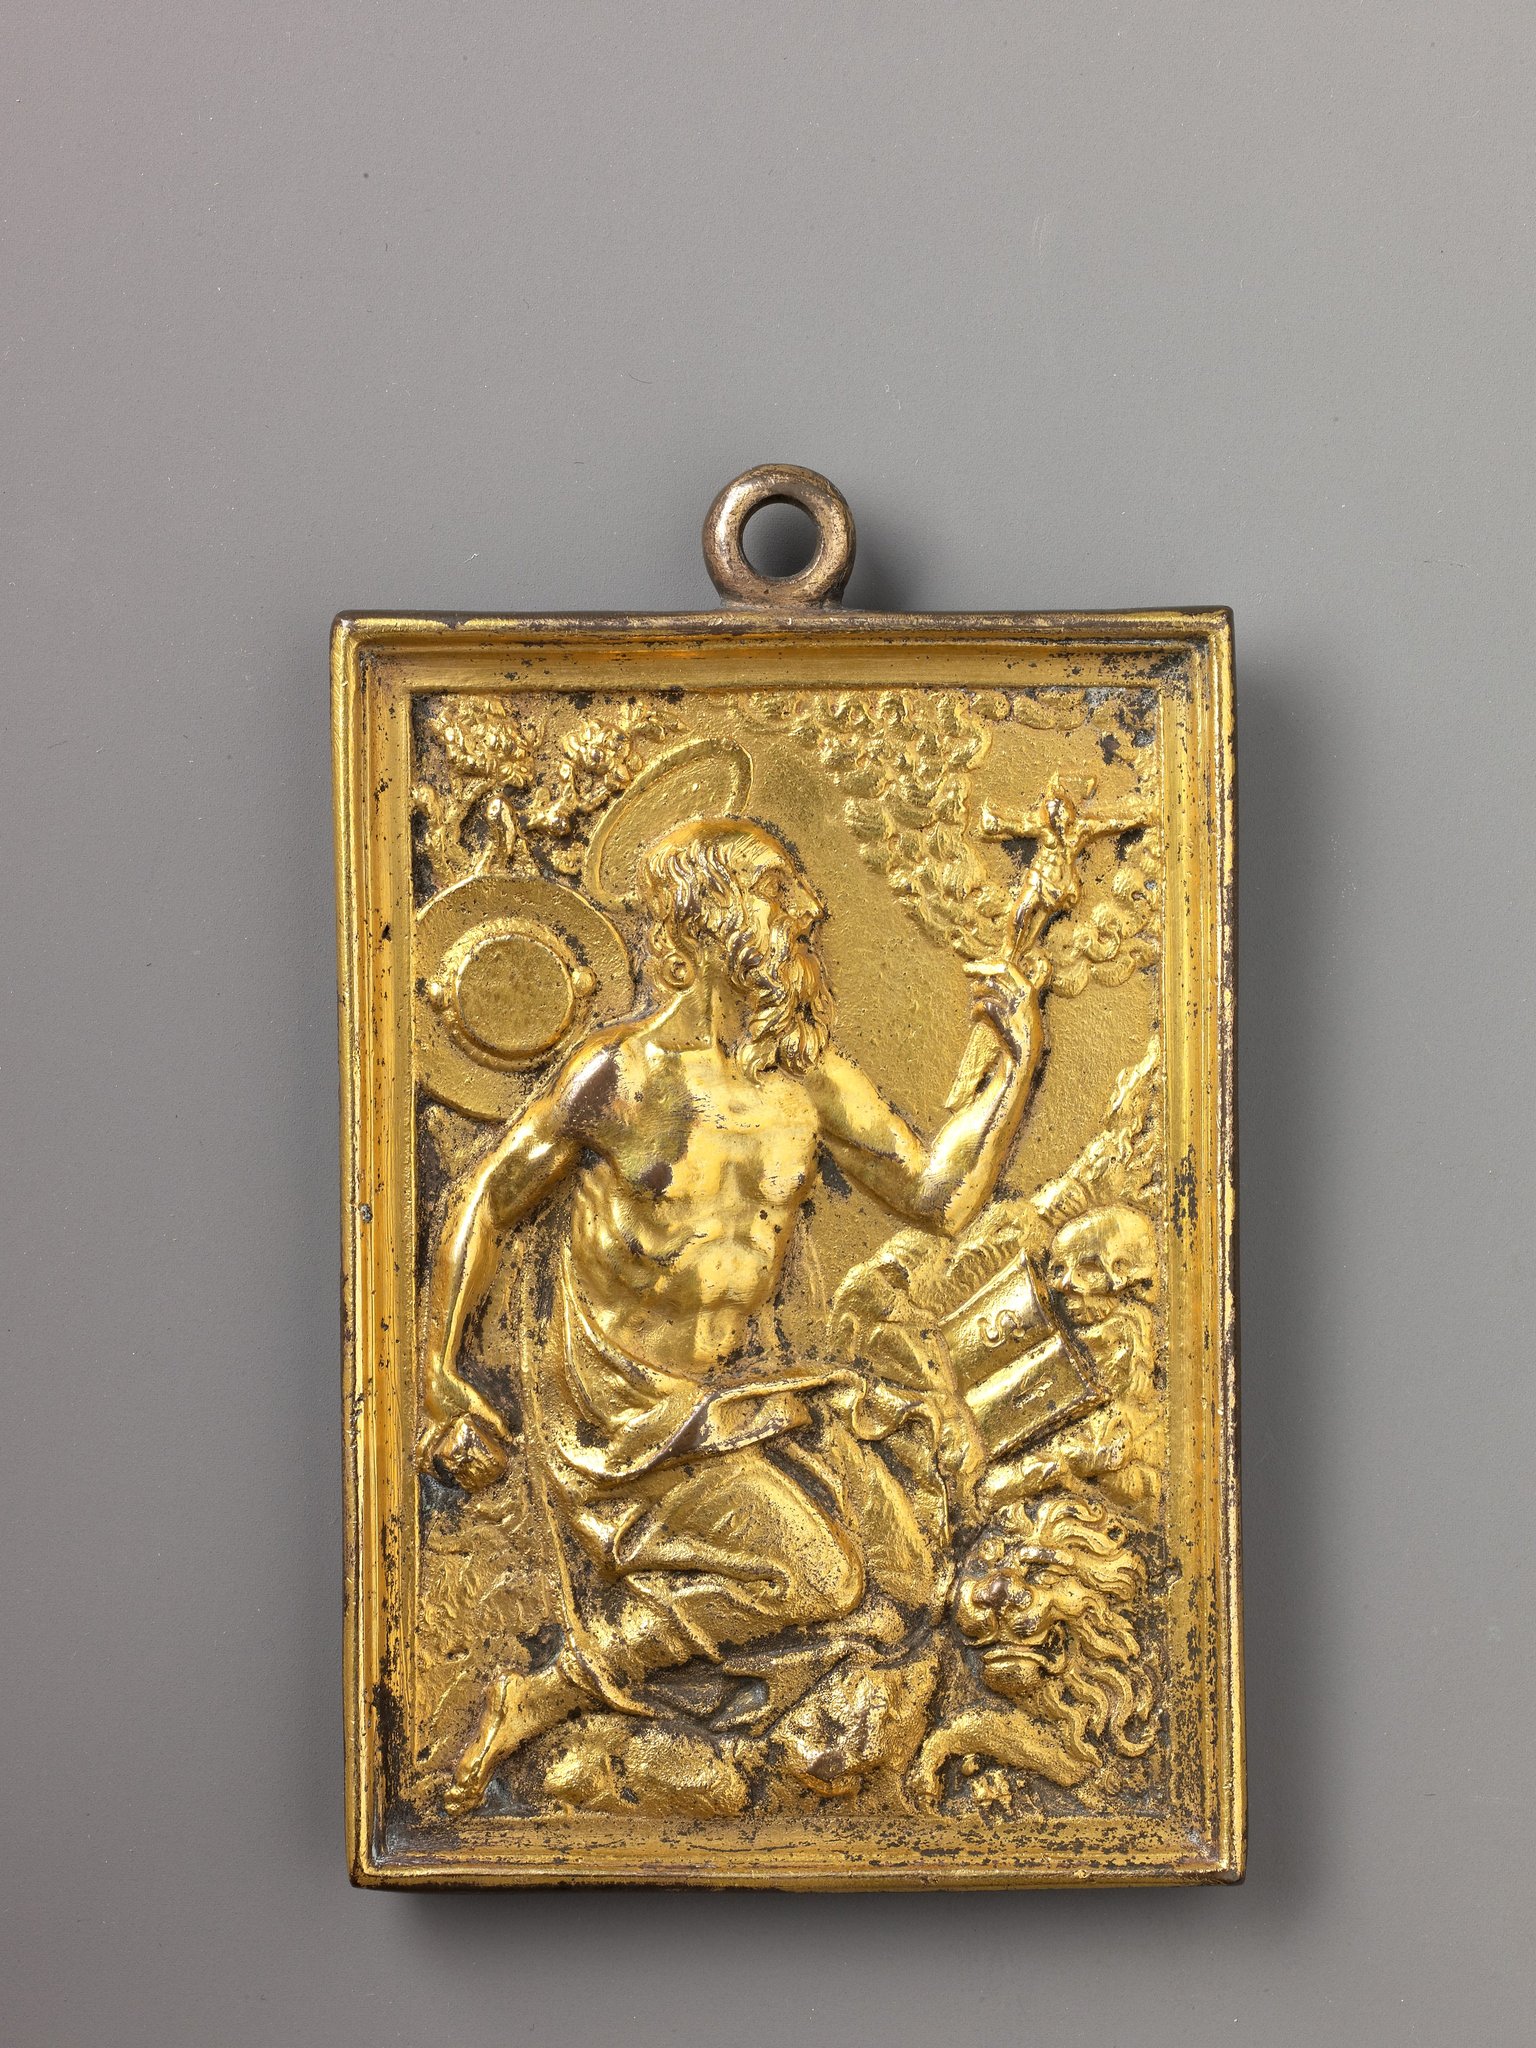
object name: plaquette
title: Saint Jerome Praying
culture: italian or spanish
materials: copper alloy, gilt, patina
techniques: casting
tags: saint jerome